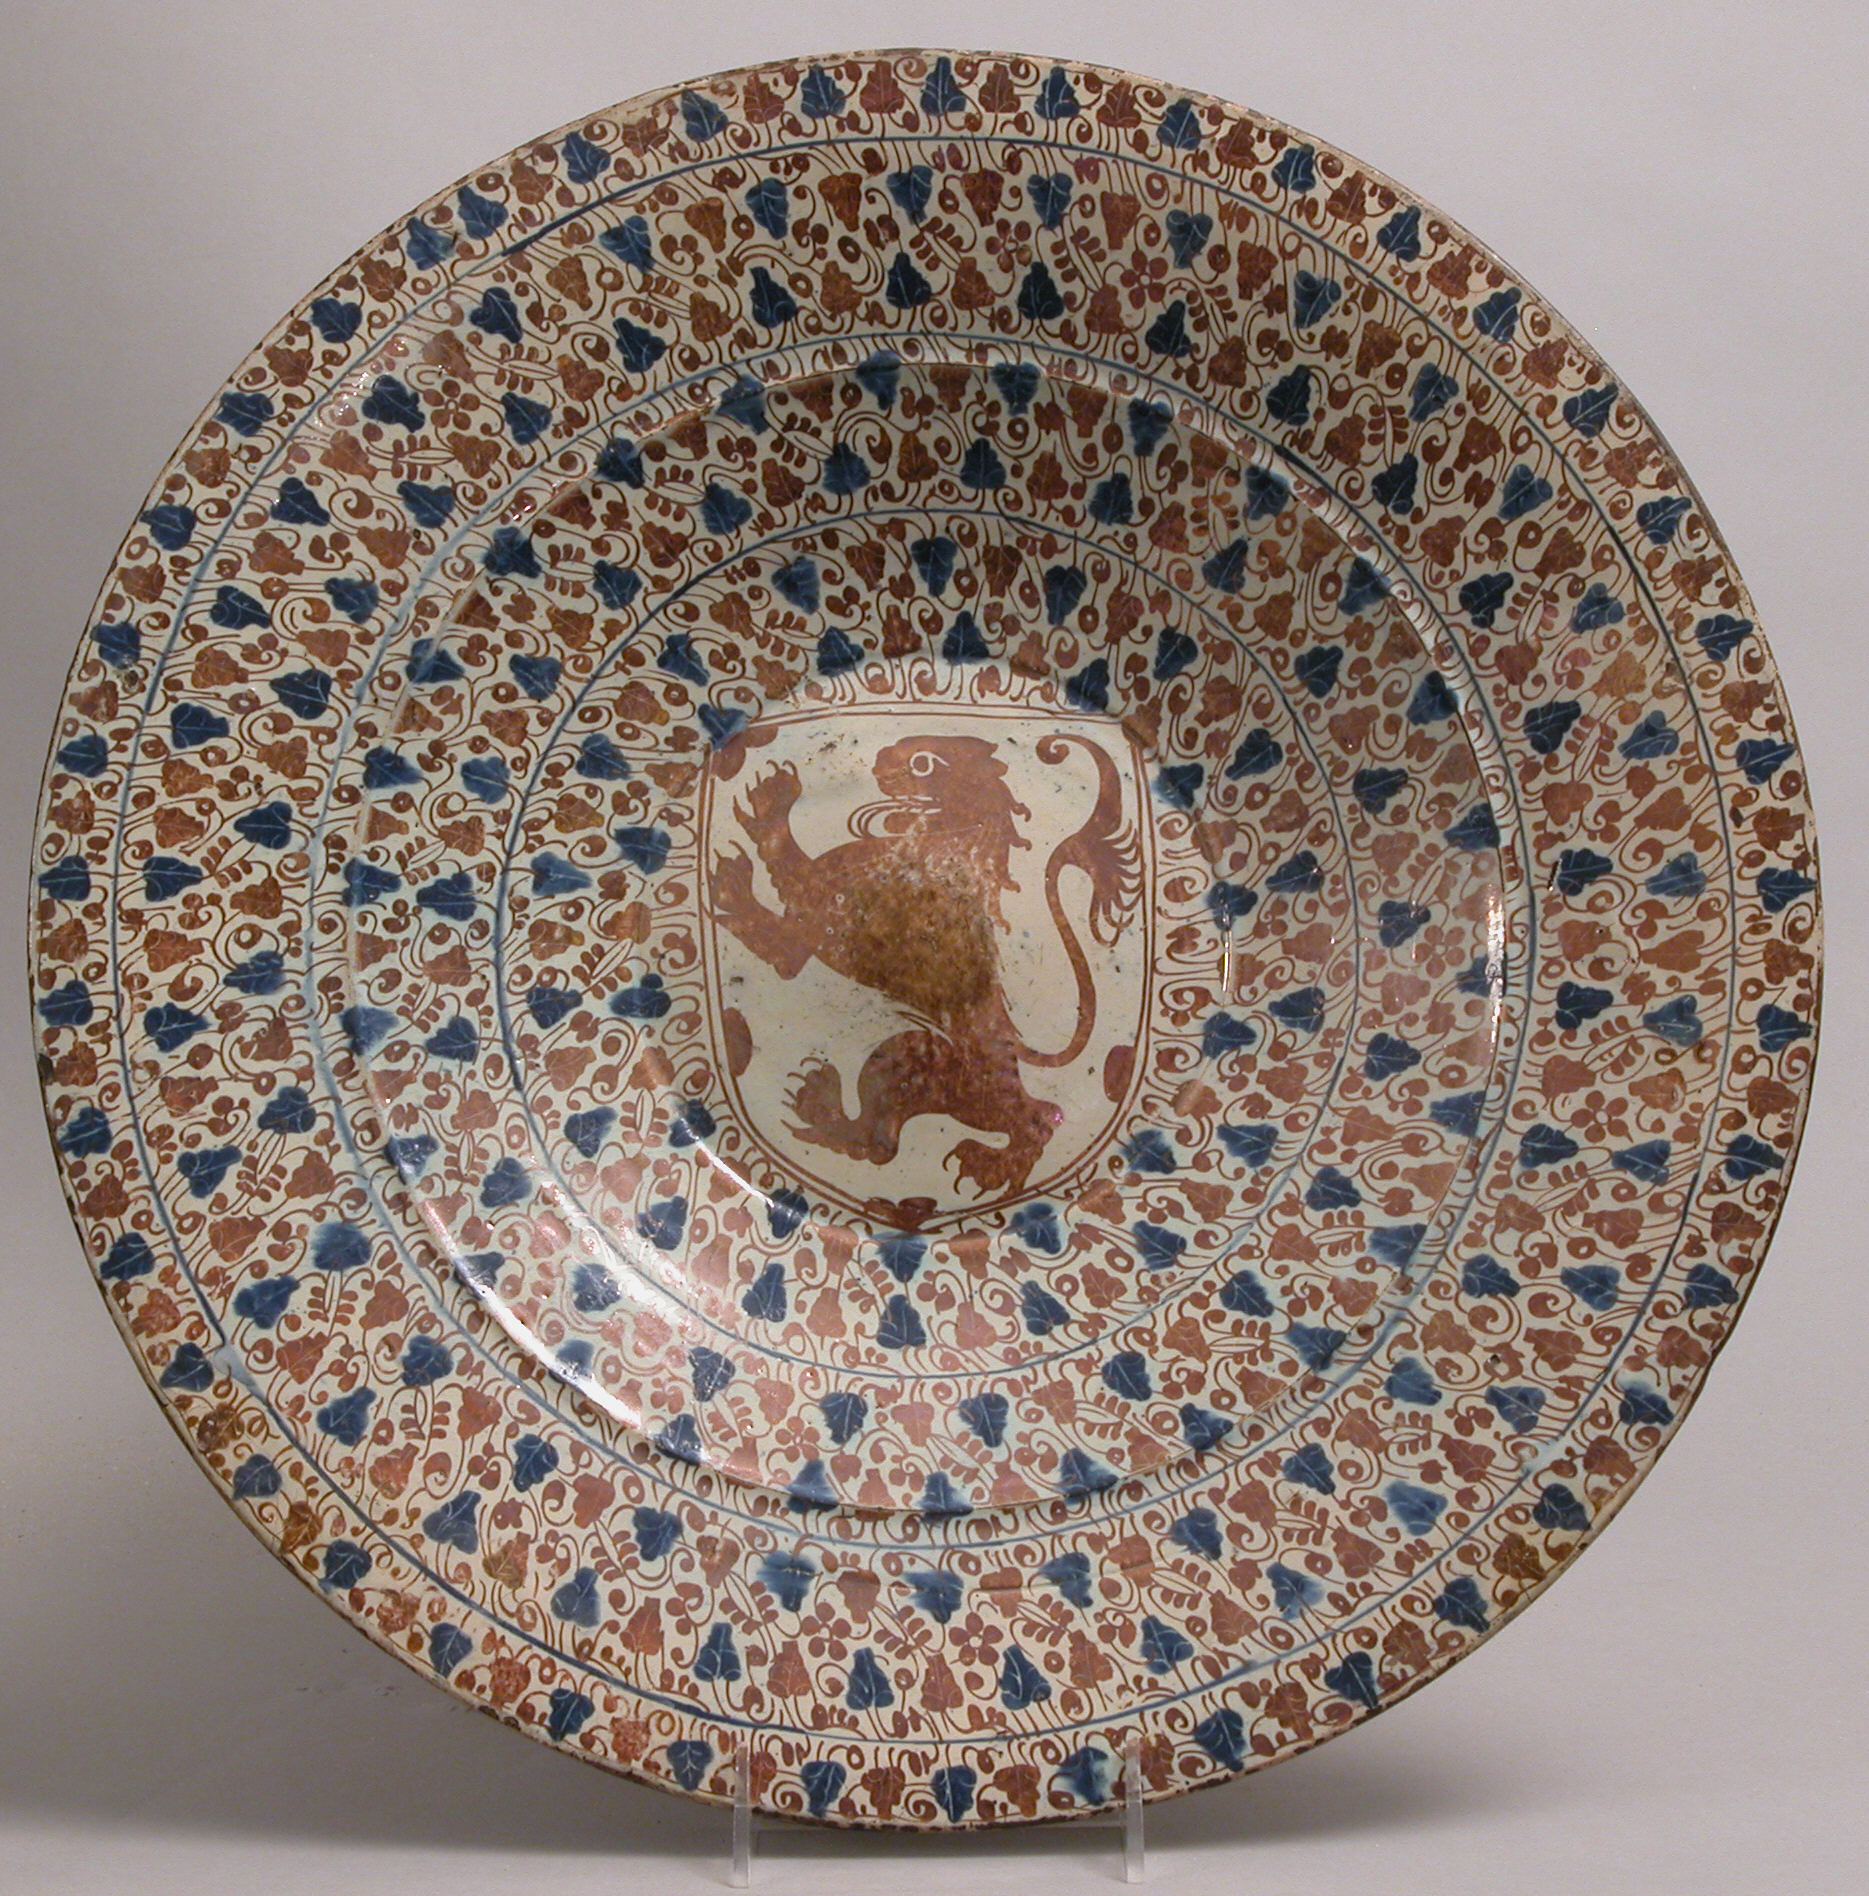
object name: plate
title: Plate with Heraldic Shield of a Rampant Lion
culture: spanish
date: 1450-1475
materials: earthenware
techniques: glazing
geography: spain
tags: shields,lions